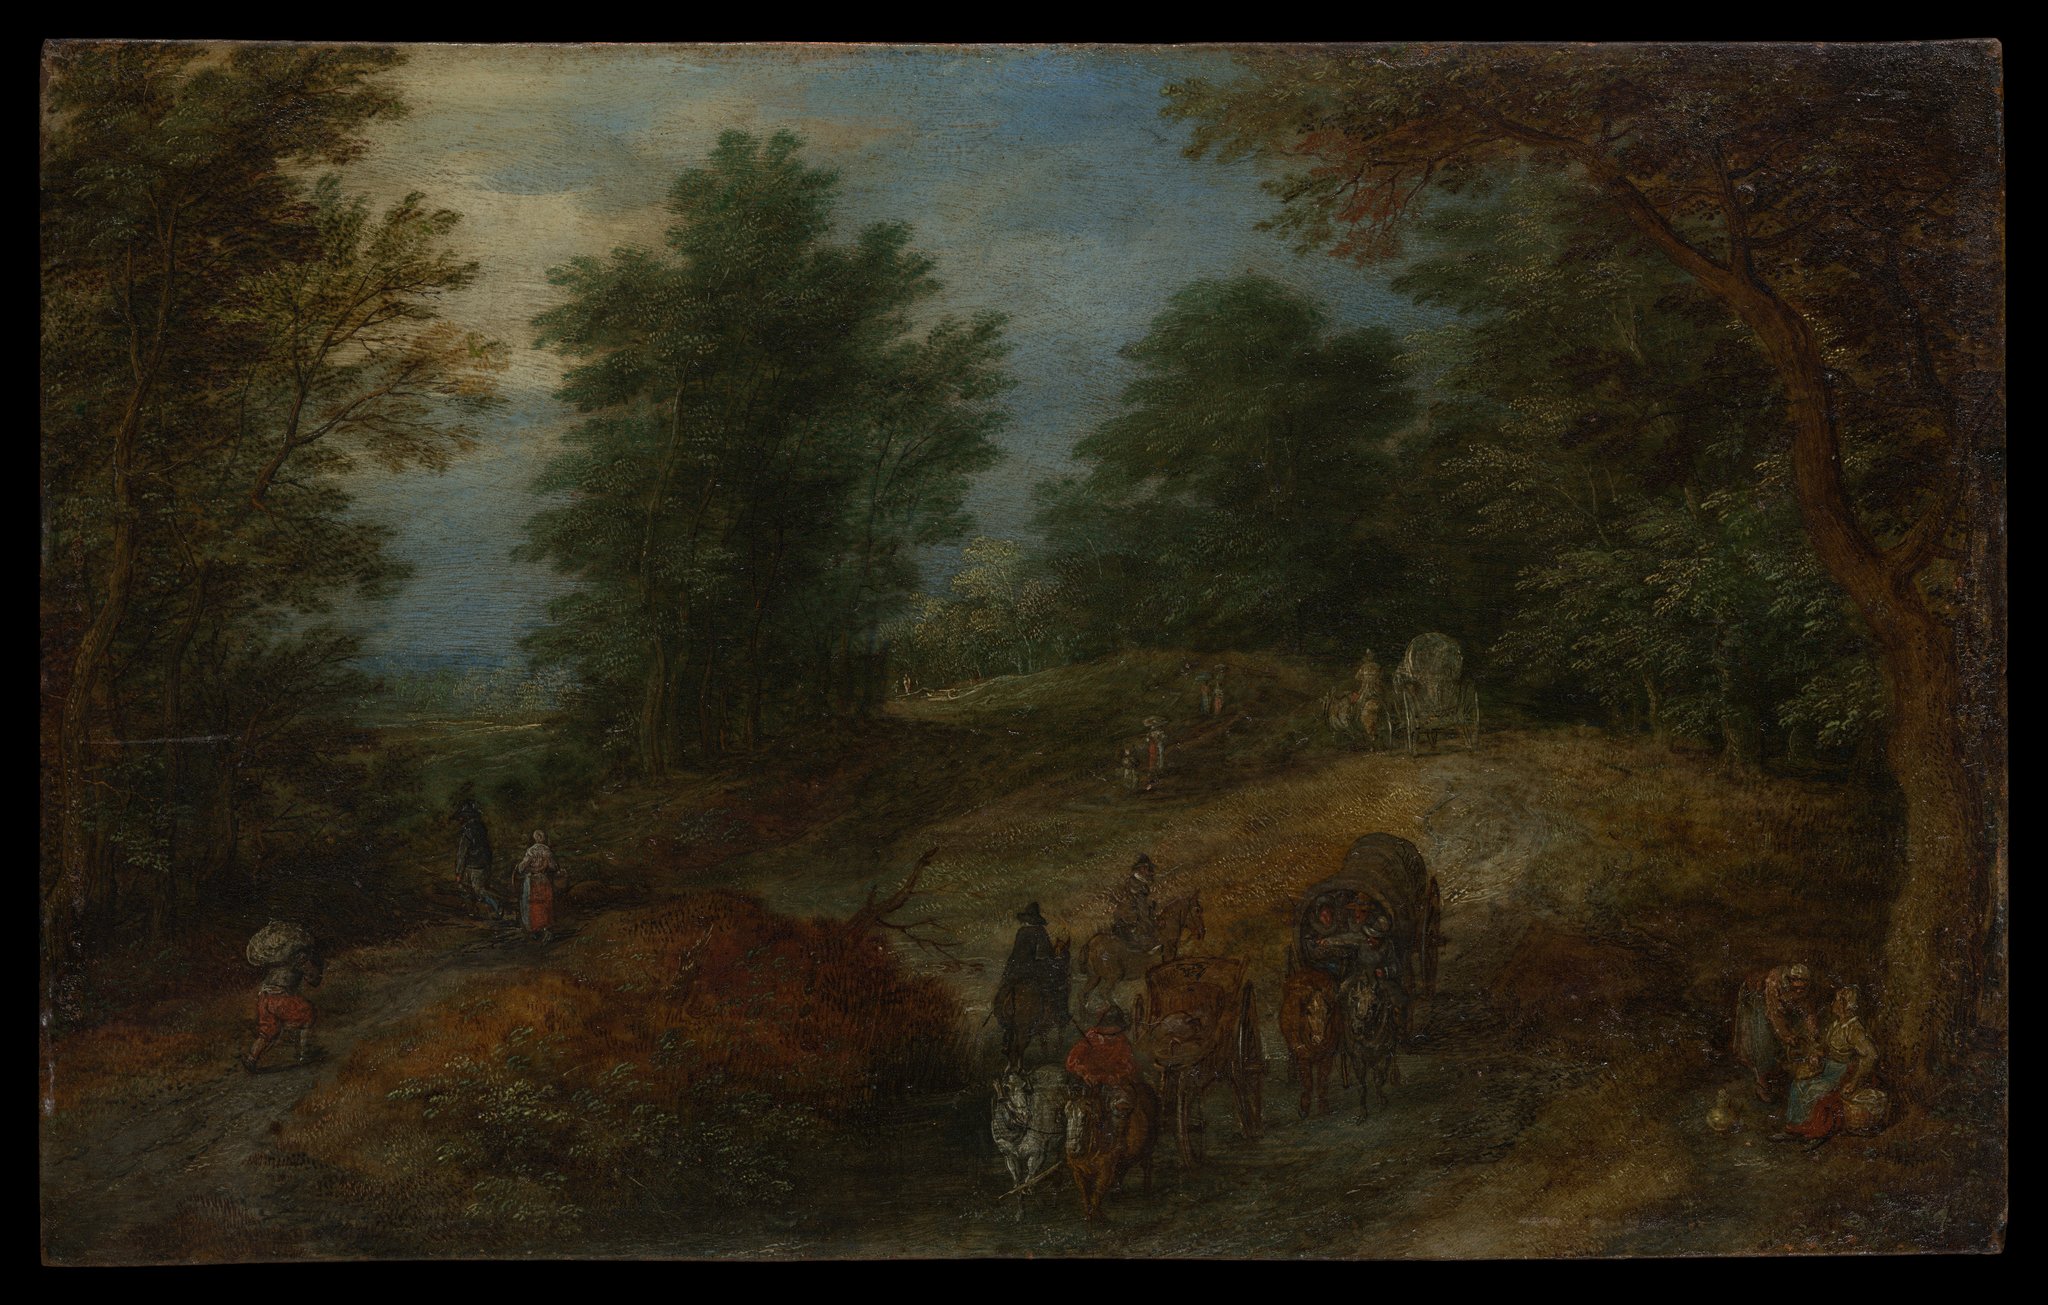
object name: painting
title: Landscape with Travelers on a Woodland Path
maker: jan brueghel the elder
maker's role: artist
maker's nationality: netherlandish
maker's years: 1568-1625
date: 1607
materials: copper, oil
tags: men,women,horses,landscapes,wagons